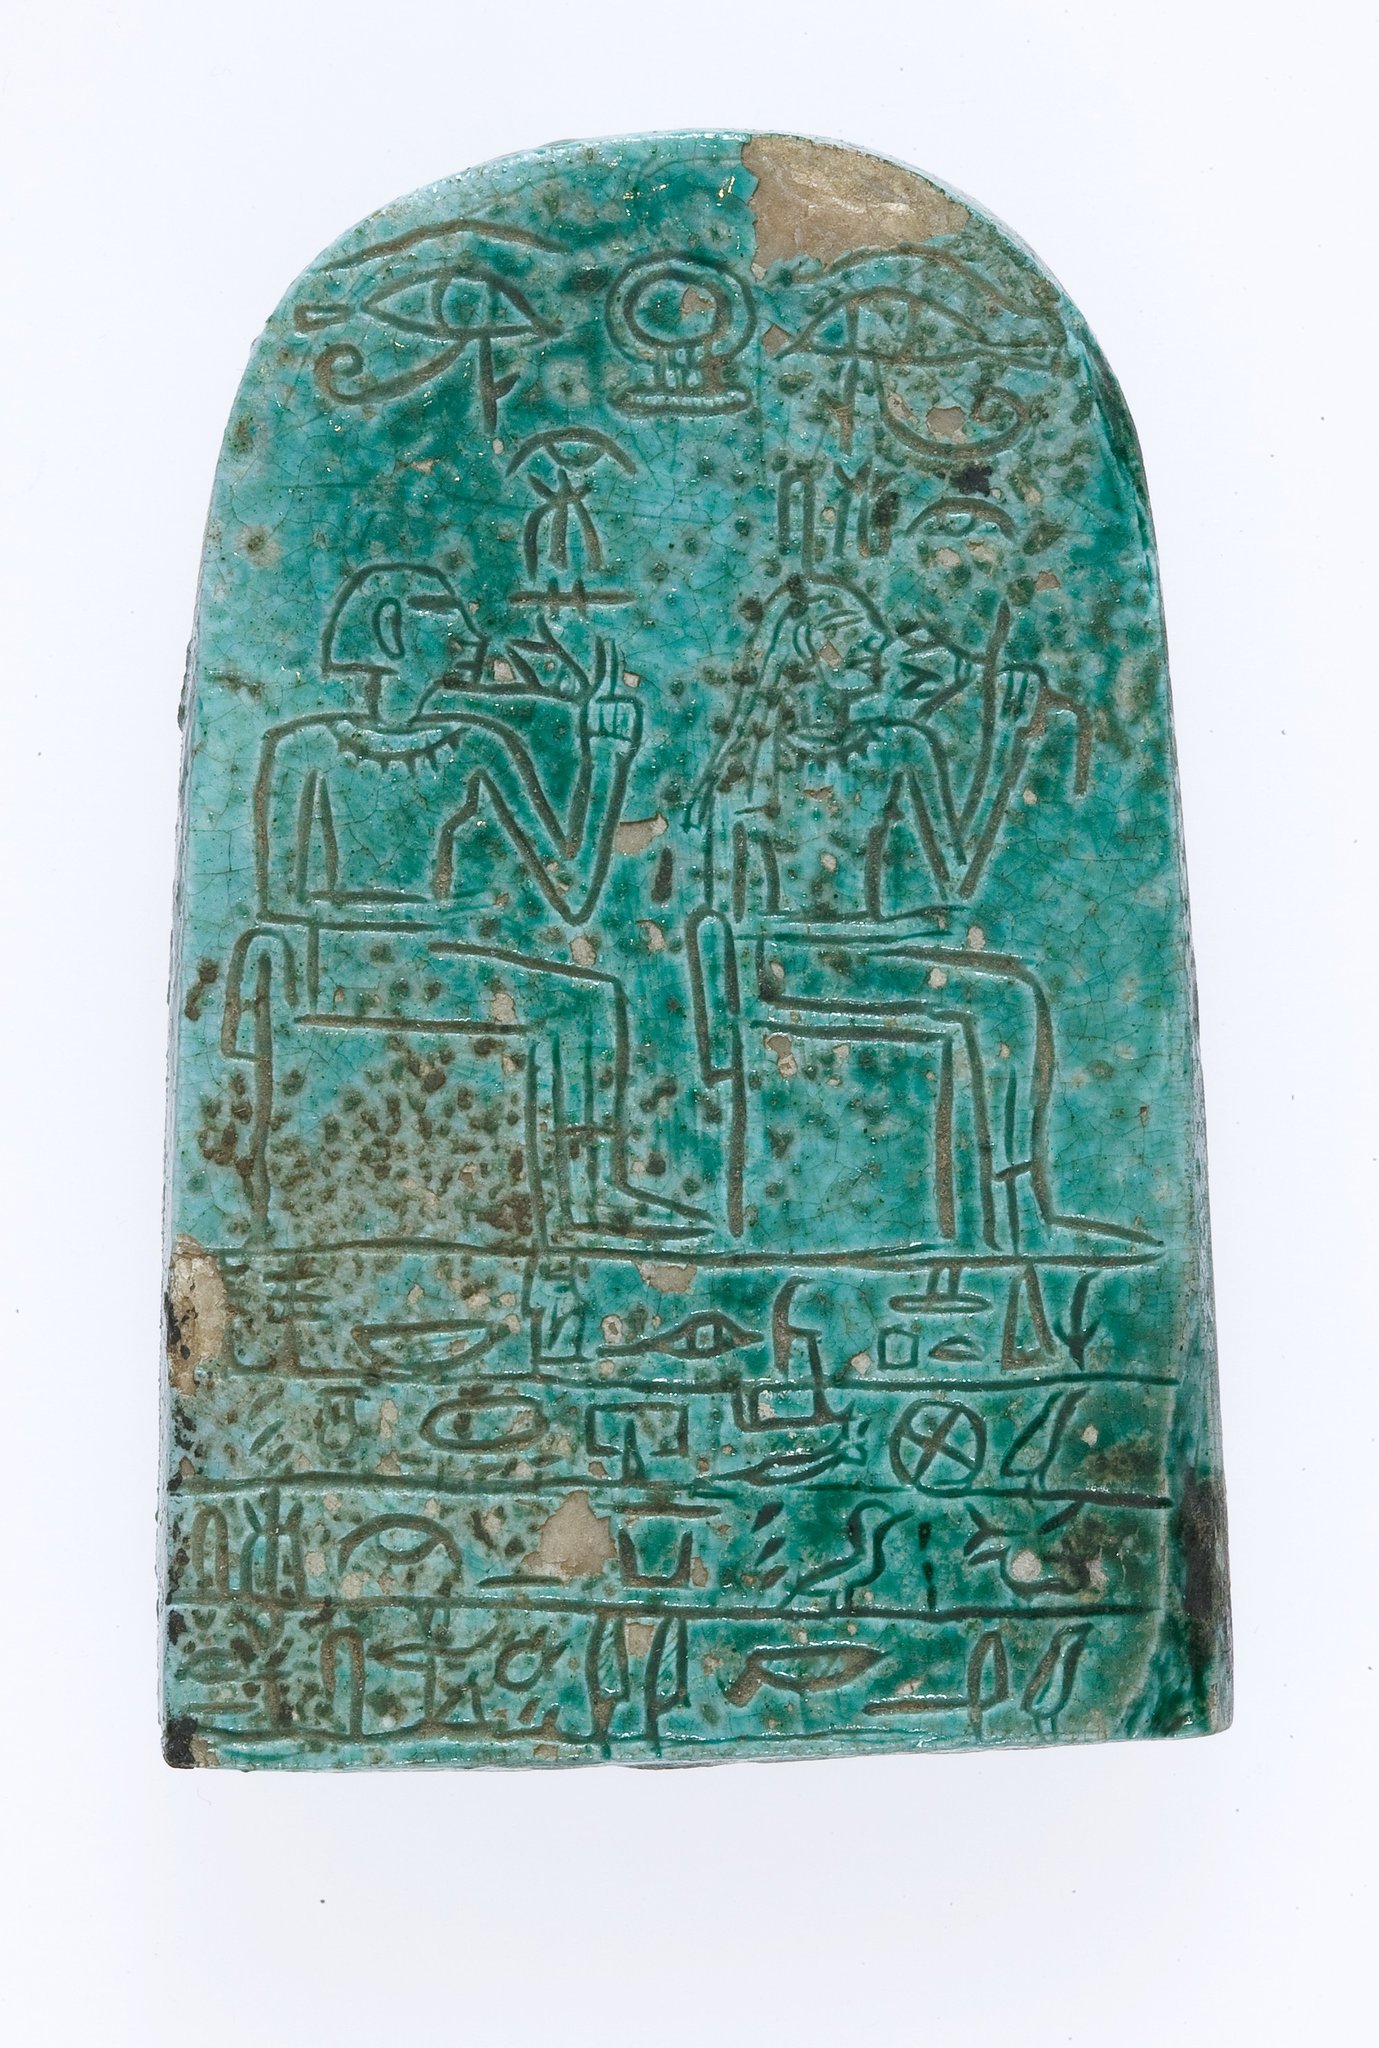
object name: stela, miniature, ahmose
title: Miniature Stela of Ahmose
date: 1600-1500 BCE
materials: stone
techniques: glazing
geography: egypt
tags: men,women,hieroglyphs